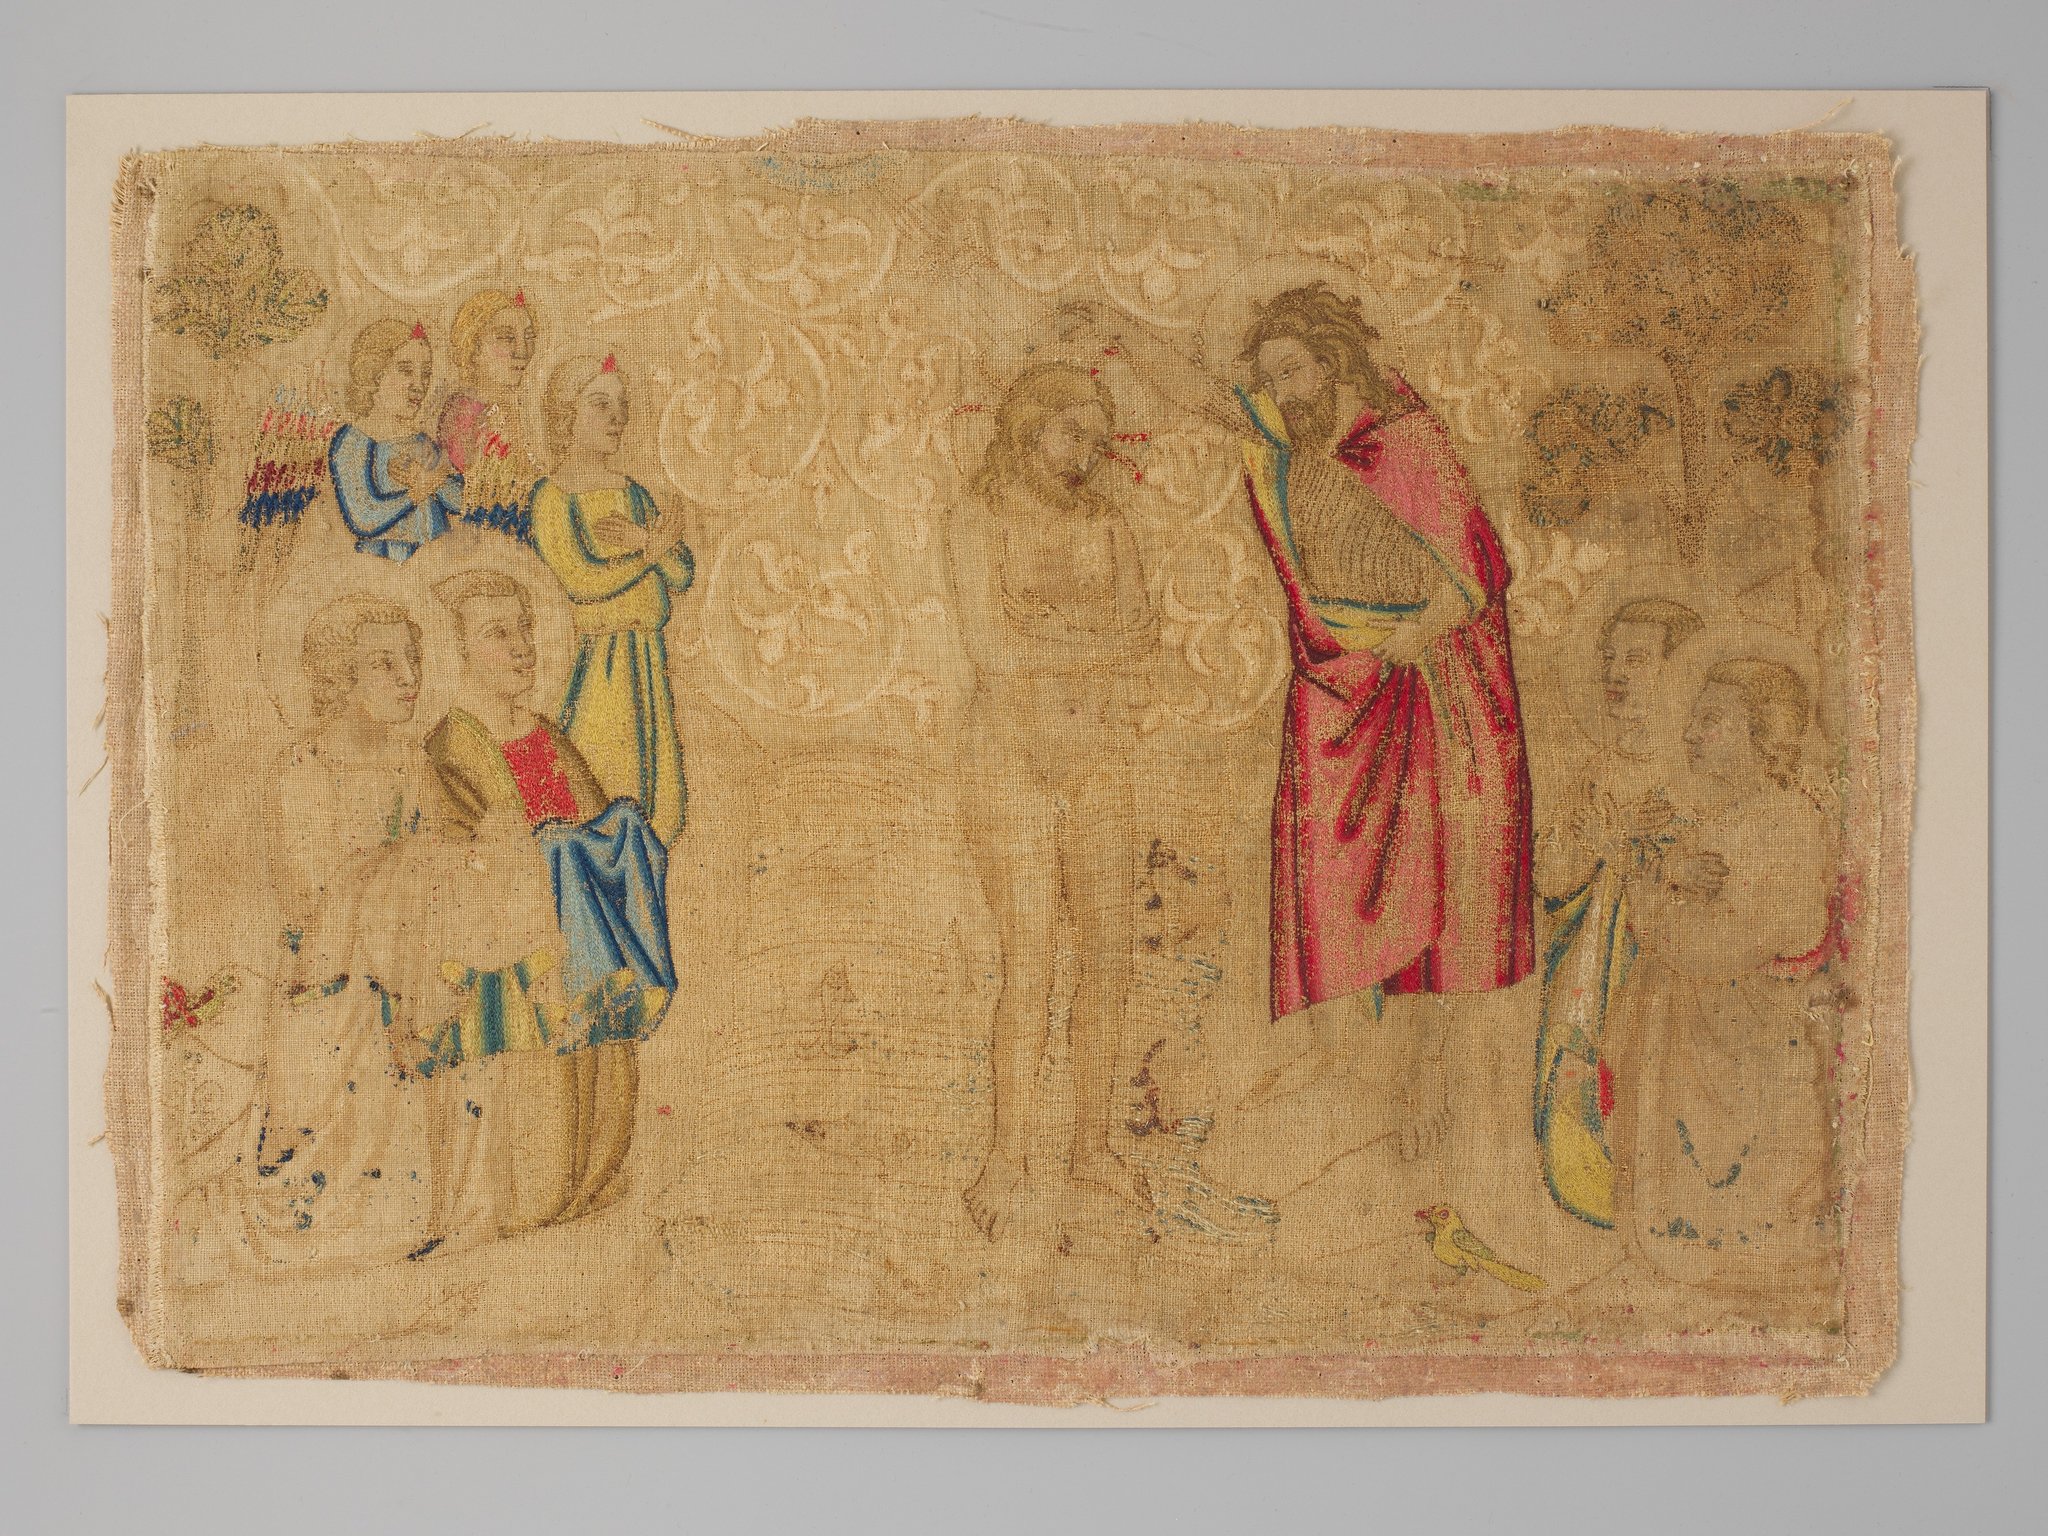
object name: panel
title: The baptism of Christ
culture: italian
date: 1301-1400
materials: linen, silk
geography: italy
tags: angels,christ,saint john the baptist,saints